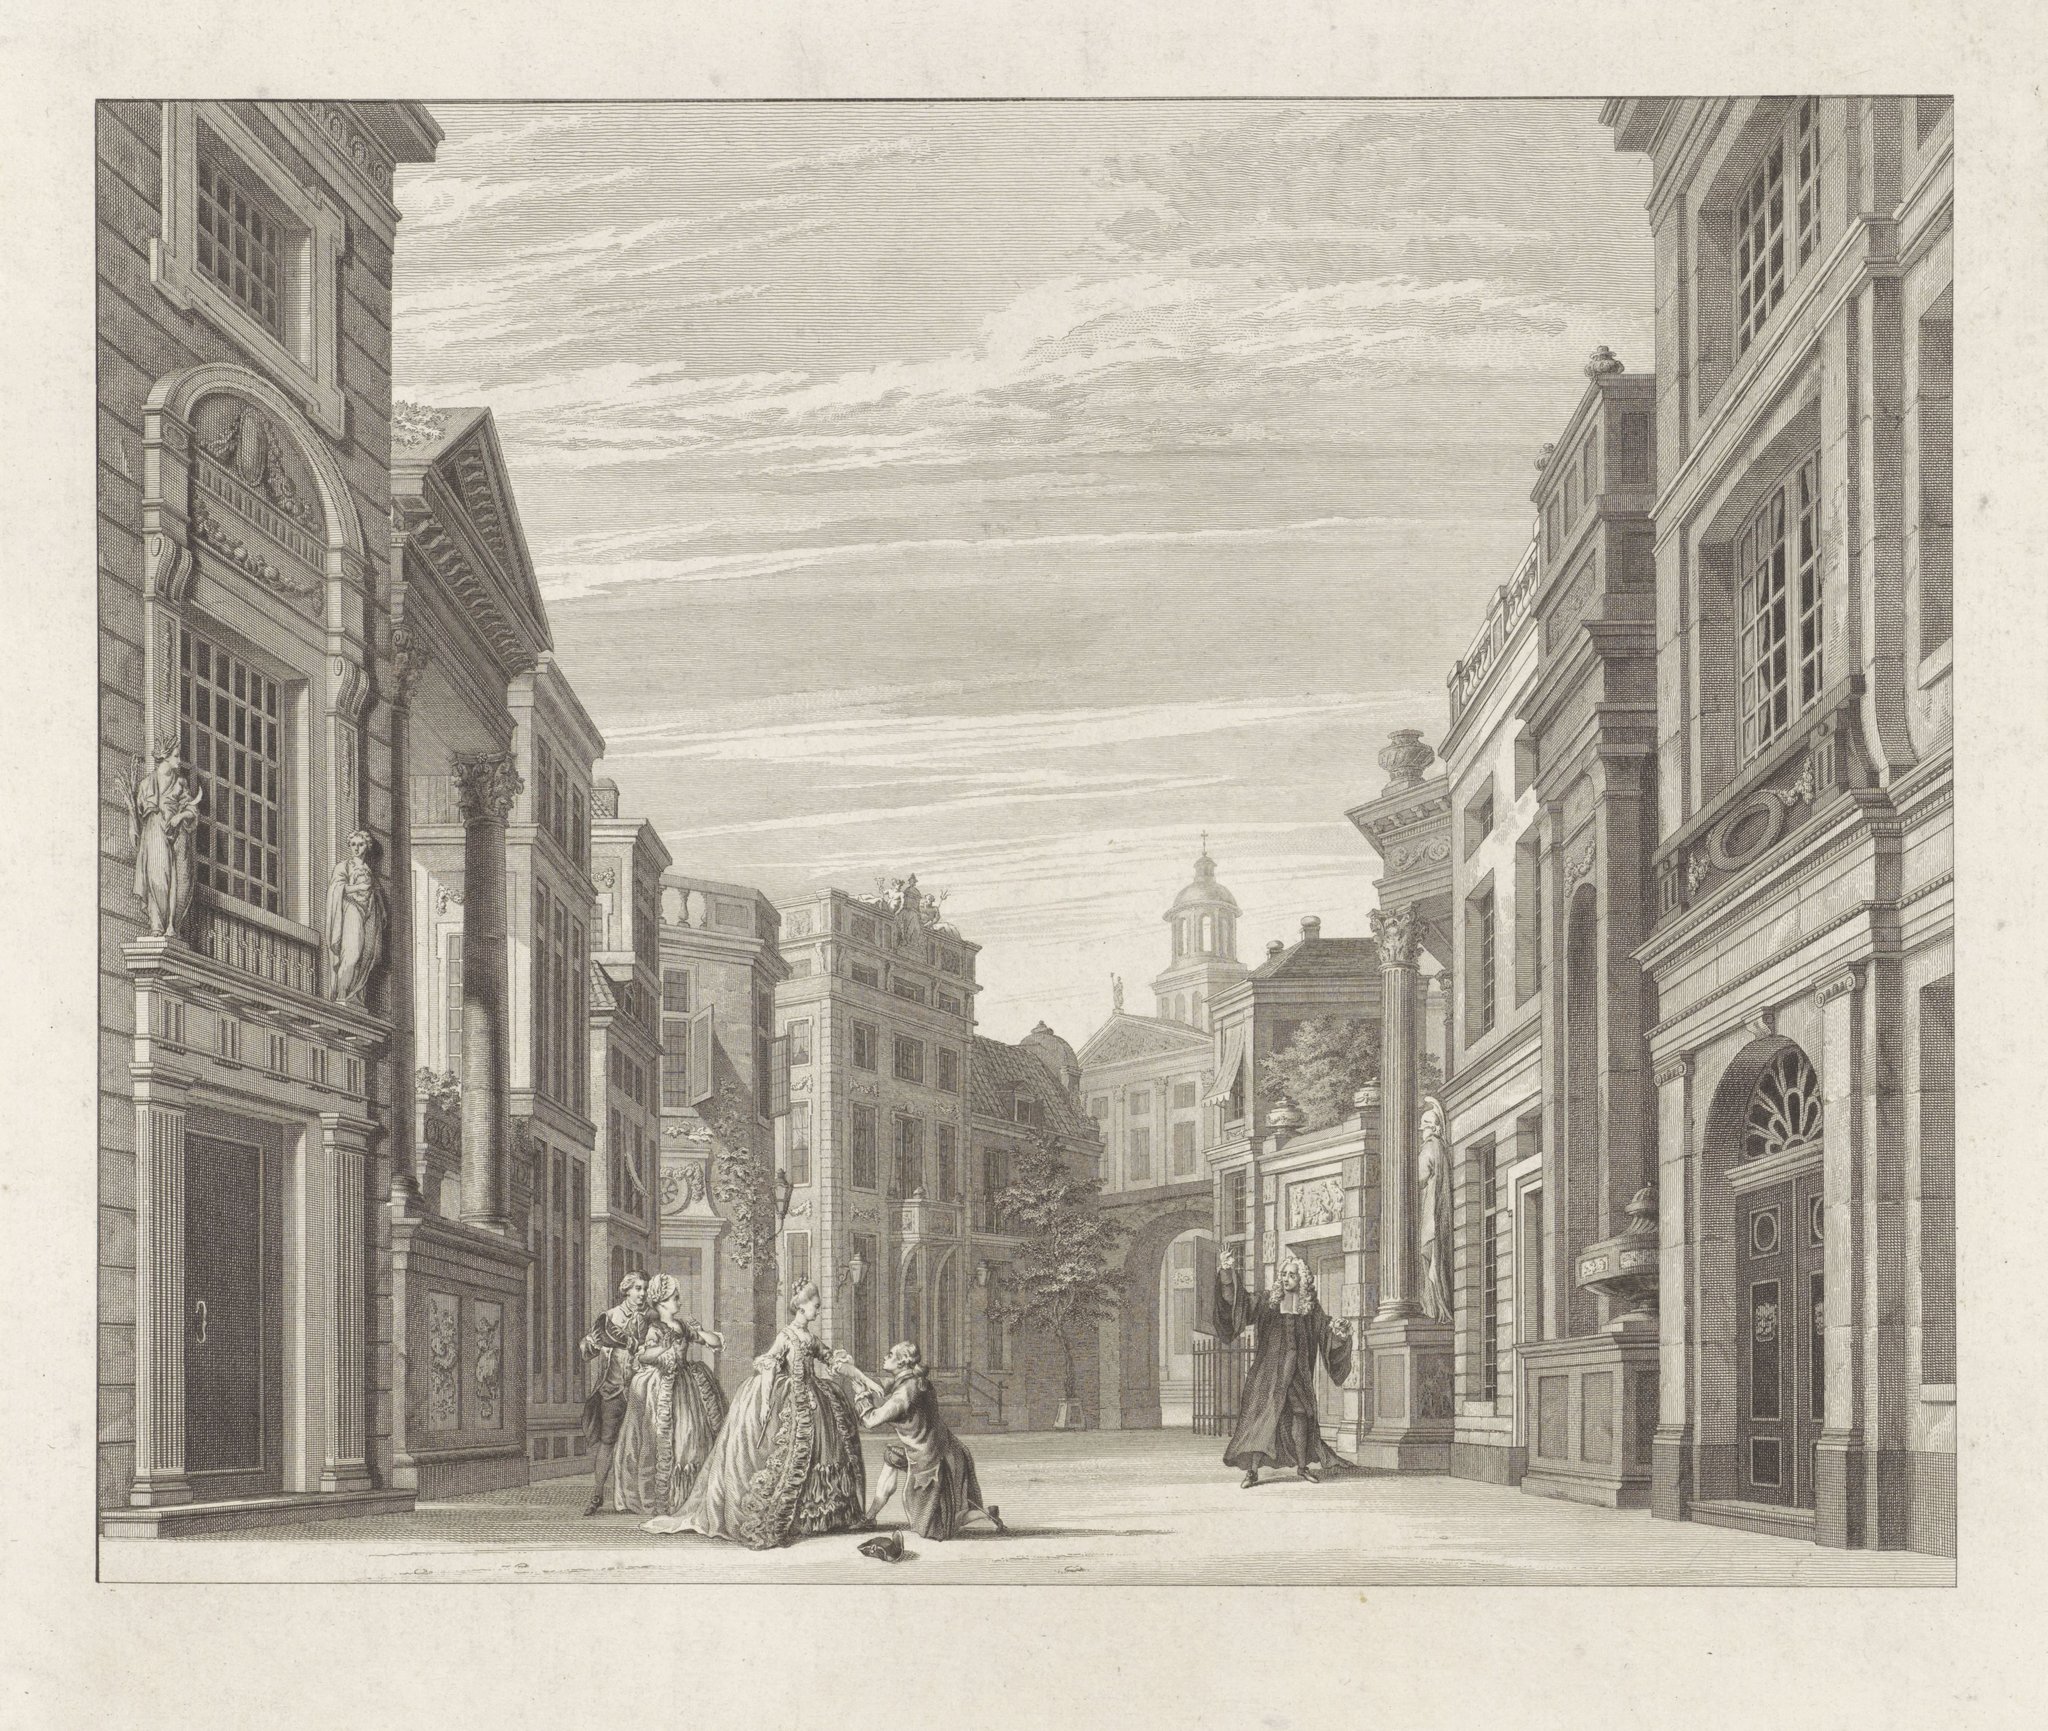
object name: print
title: Toneeldecors van de nieuwe Amsterdamse Schouwburg, 1775-1777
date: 1775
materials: paper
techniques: engraving, etching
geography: amsterdam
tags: paris, voltaire, theatre, theatrical performance, stage design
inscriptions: collector's mark: Lugt 240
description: Het coulissendecor De Italiaansche Straat, met een scène uit: Wedergevonden zoon. Onderdeel van een serie van zes toneeldecors van toneelstukken opgevoerd in de nieuwe Amsterdamse Schouwburg uit de jaren 1775-1777.